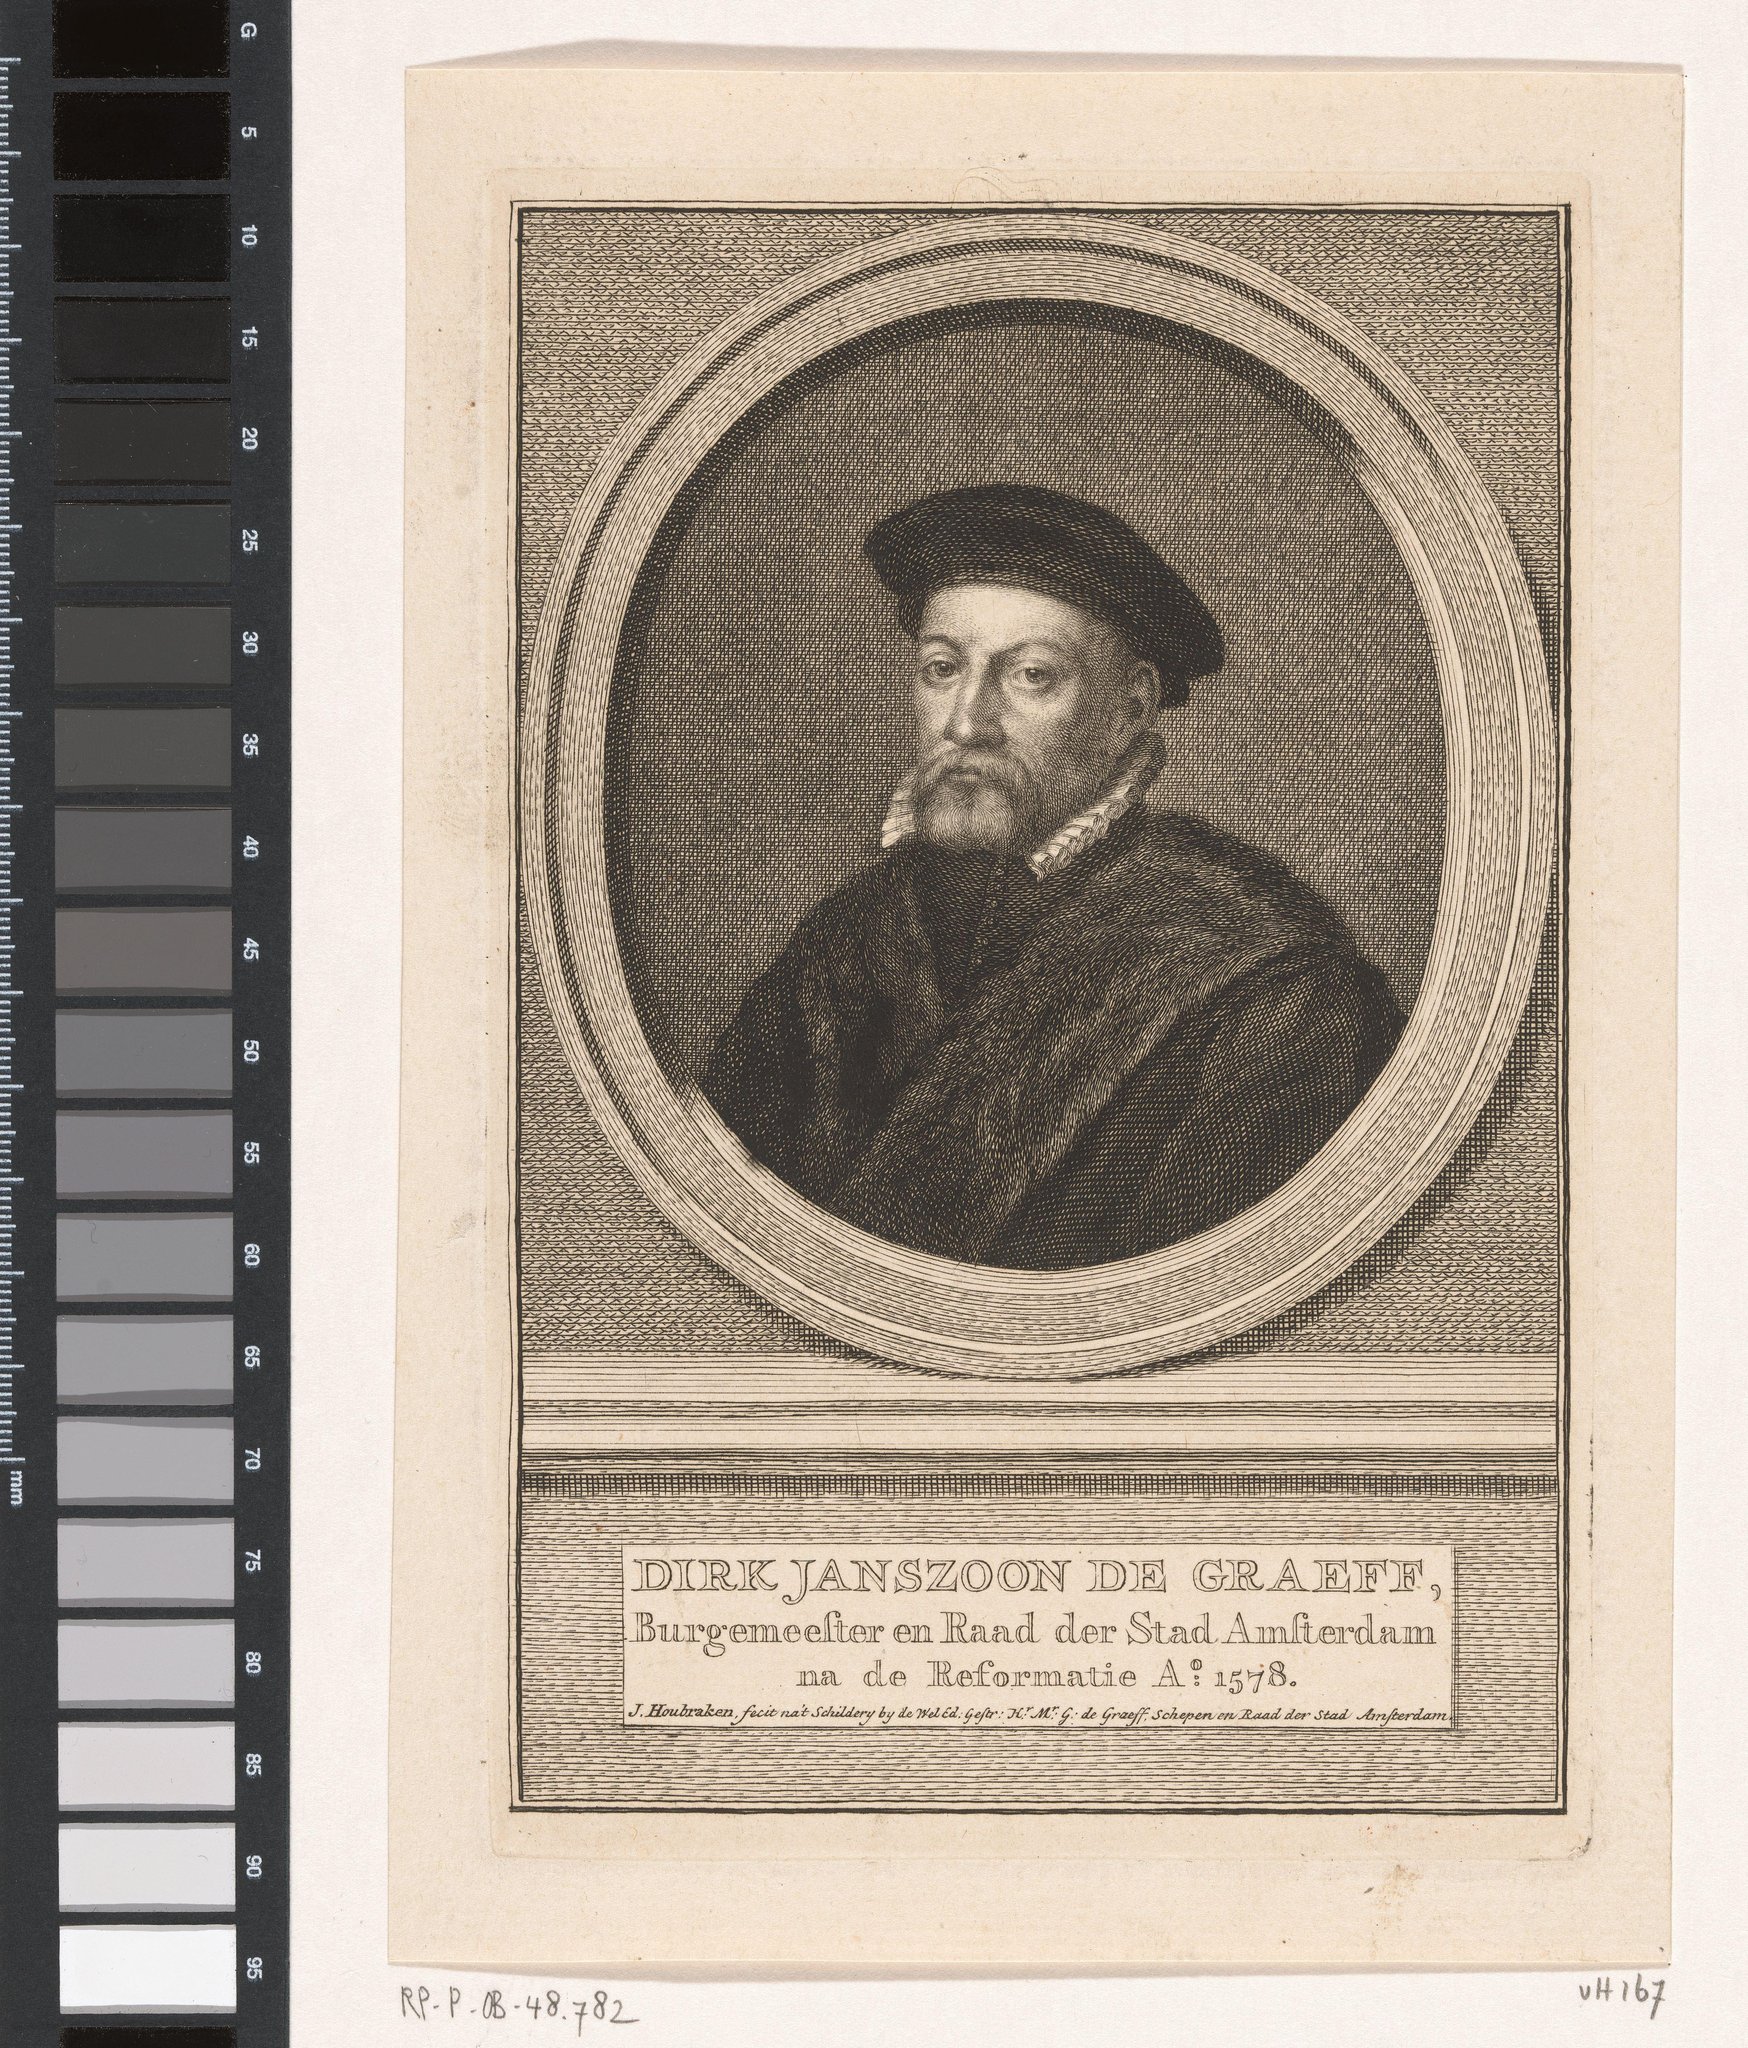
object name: print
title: Portret van Dirk Janszoon de Graeff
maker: jacob houbraken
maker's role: draughtsman, print maker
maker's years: 1698-1780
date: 1749-1780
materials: paper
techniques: engraving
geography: amsterdam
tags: amsterdam, politician, historical persons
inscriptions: collector's mark: Lugt 240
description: Deze prent is oorspronkelijk bedoeld als aanvulling op Jan Wagenaars ‘Vaderlandsche historie’* en was zo vanaf 1796 verkrijgbaar bij Johannes Allart te Amsterdam. Voor de advertentie waarin Allart de 60 portretten en 7 platen, allen gegraveerd door Houbraken, ter aanvulling op Wagenaars ‘Vaderlandsche historie’ aanbiedt, zie RP-P-OB-77.766. *Van dit werk zijn in de achttiende eeuw meerdere uitgaves verschenen, zoals: Wagenaar, Jan. Vaderlandsche historie, vervattende de geschiedenissen der Vereenigde Nederlanden (…). 21 delen. Amsterdam: Isaak Tirion, 1749-1759. Wagenaar, Jan. Vaderlandsche historie, vervattende de geschiedenissen der nu Vereenigde Nederlanden (…). 21 delen. Amsterdam: weduwe Isaak Tirion, 1770. Wagenaar, Jan. Vaderlandsche historie, vervattende de geschiedenissen der nu Vereenigde Nederlanden (…). 21 delen. Amsterdam, Leiden, Dordrecht en Harlingen: P. Schouten e.a., 1782. Wagenaar, Jan. Vaderlandsche historie, vervattende de geschiedenissen der nu Vereenigde Nederlanden (…). 21 delen. Amsterdam: Johannes Allart, 1790-1796.